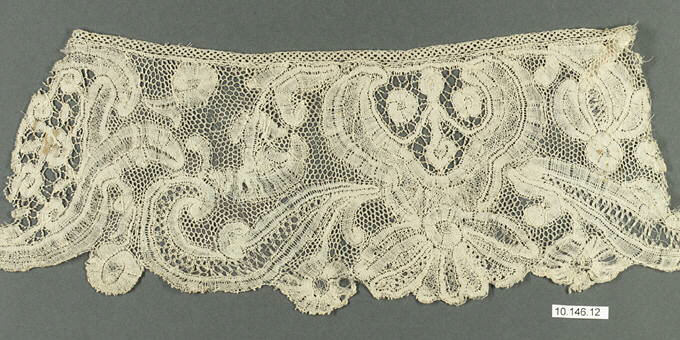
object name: fragment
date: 1701-1800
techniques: lace